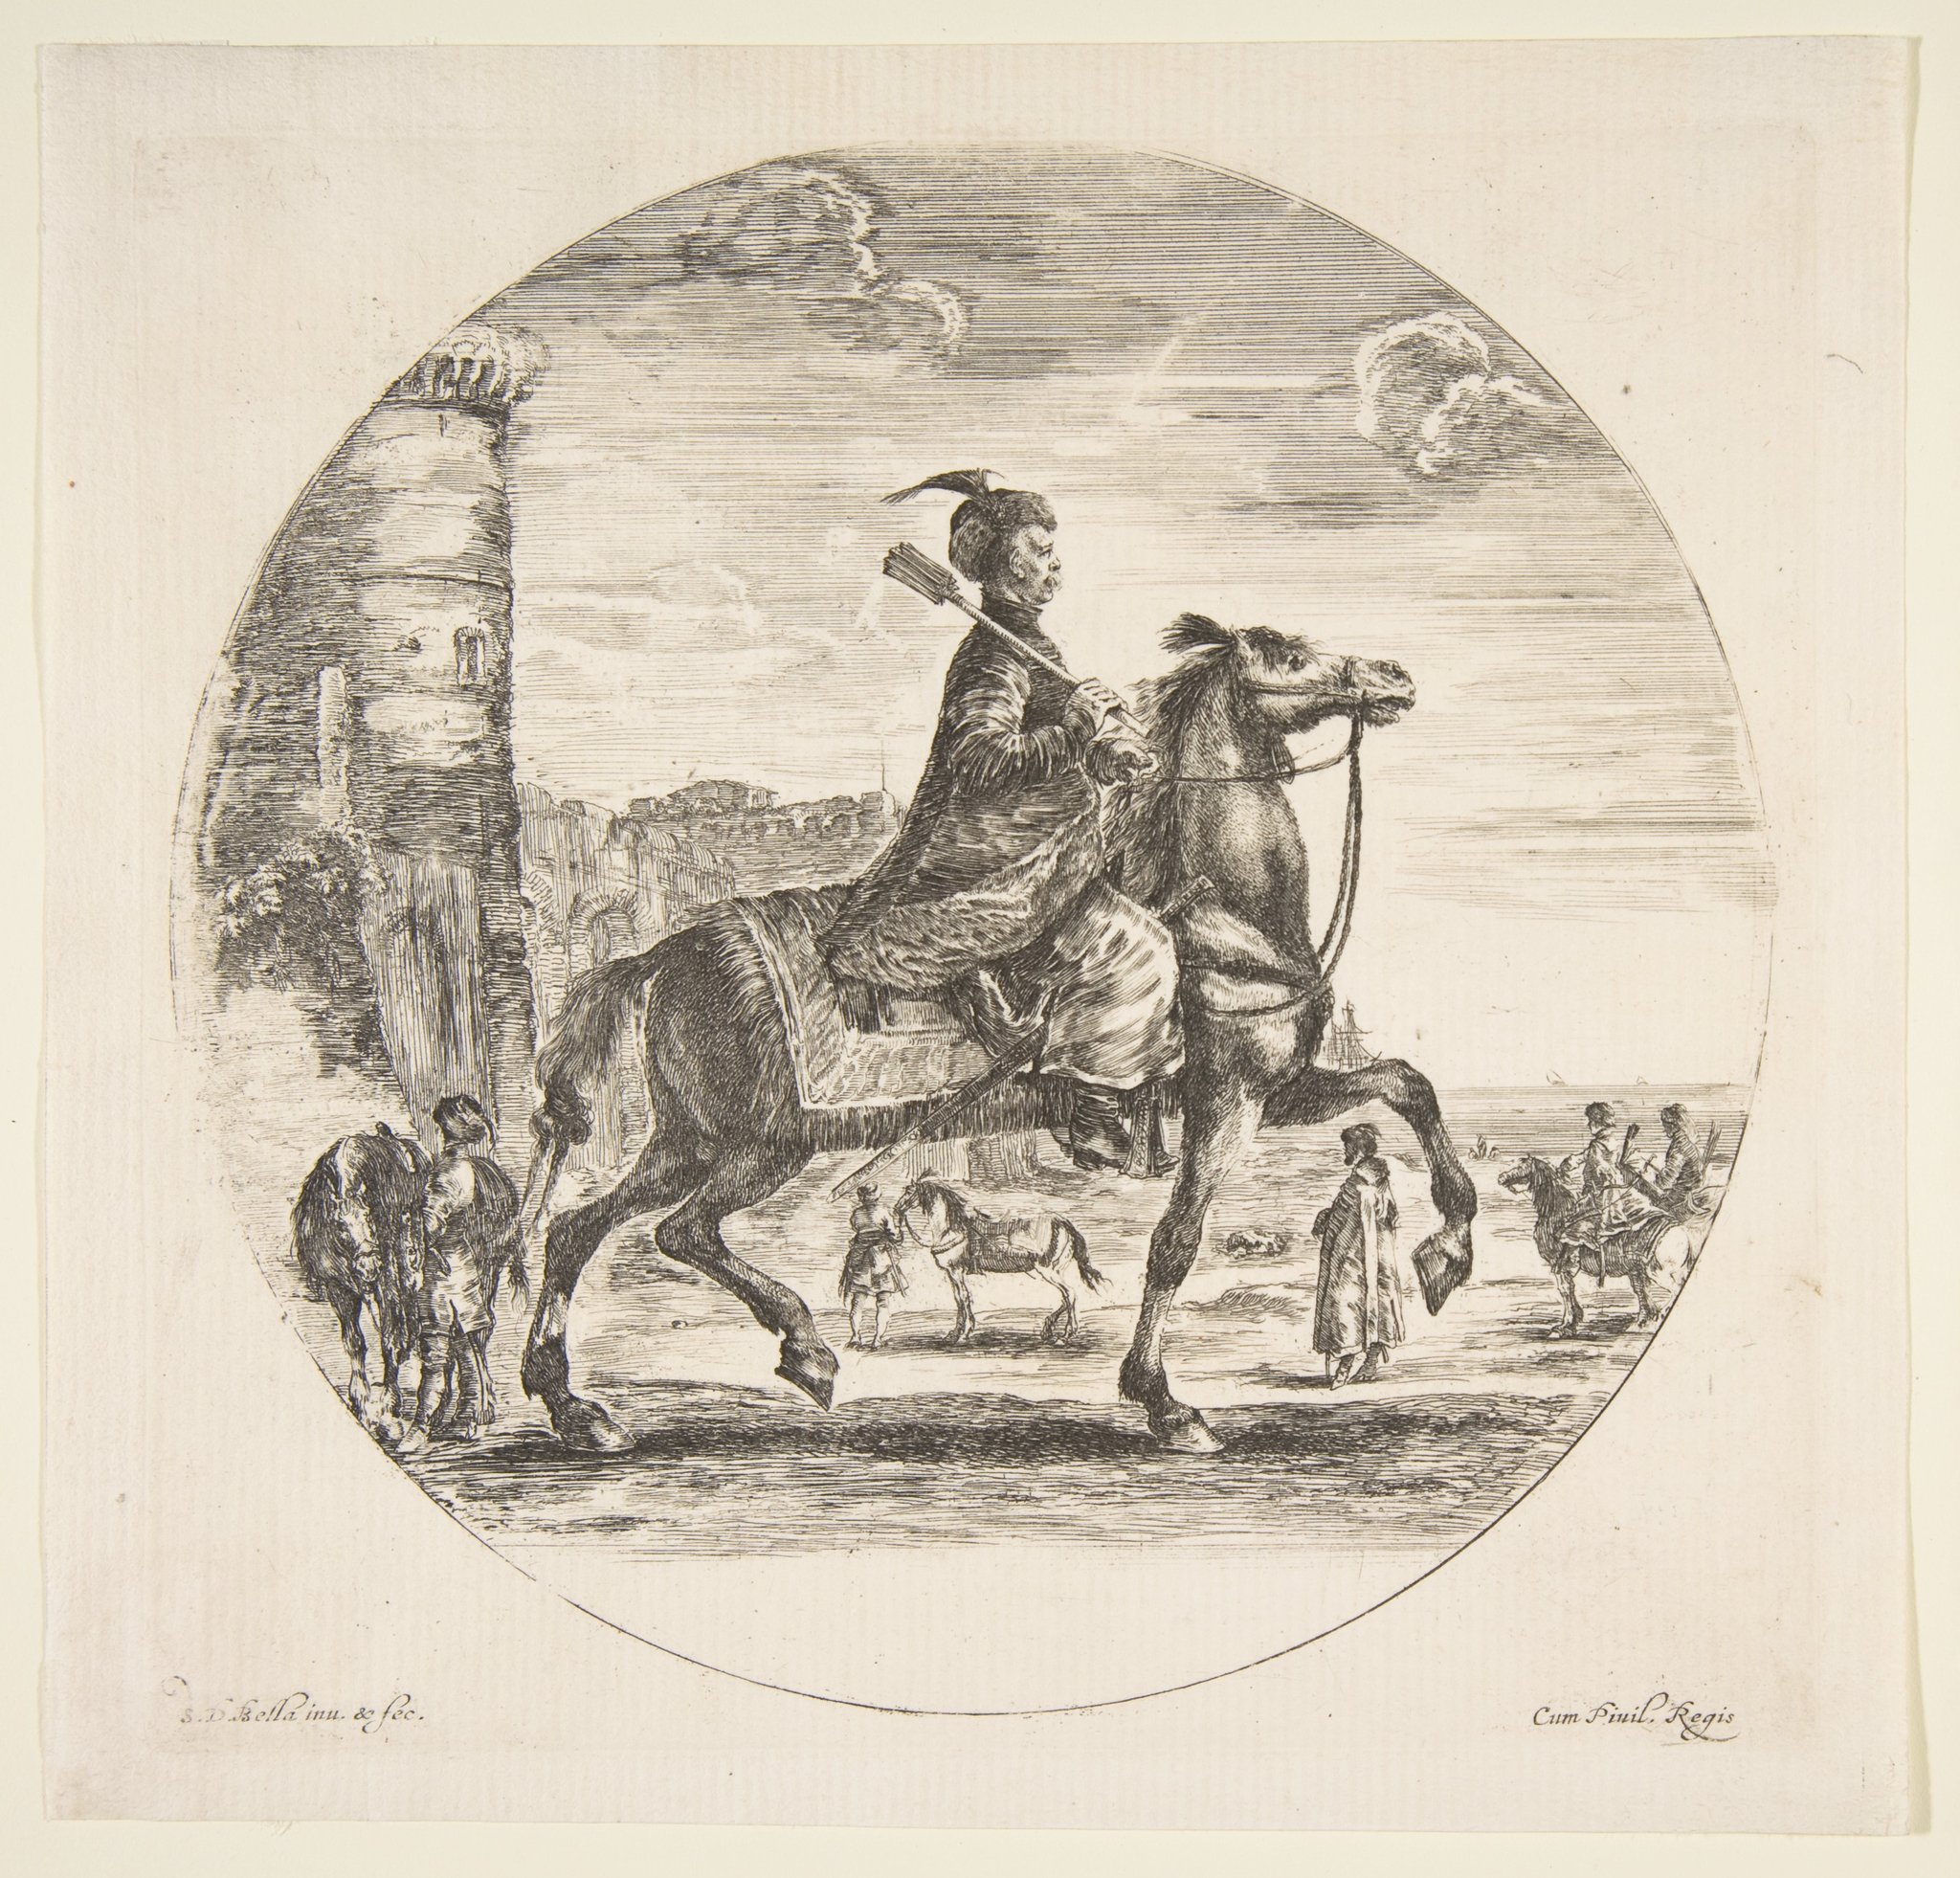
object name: print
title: Polish horseman in profile facing right, a tower and other figures on horses in background, a circular composition, from 'Figures on Horseback' (Cavaliers nègres, polonais et hongrois)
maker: stefano della bella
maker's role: artist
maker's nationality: italian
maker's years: 1610-1664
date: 1651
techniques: etching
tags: towers,men,horses